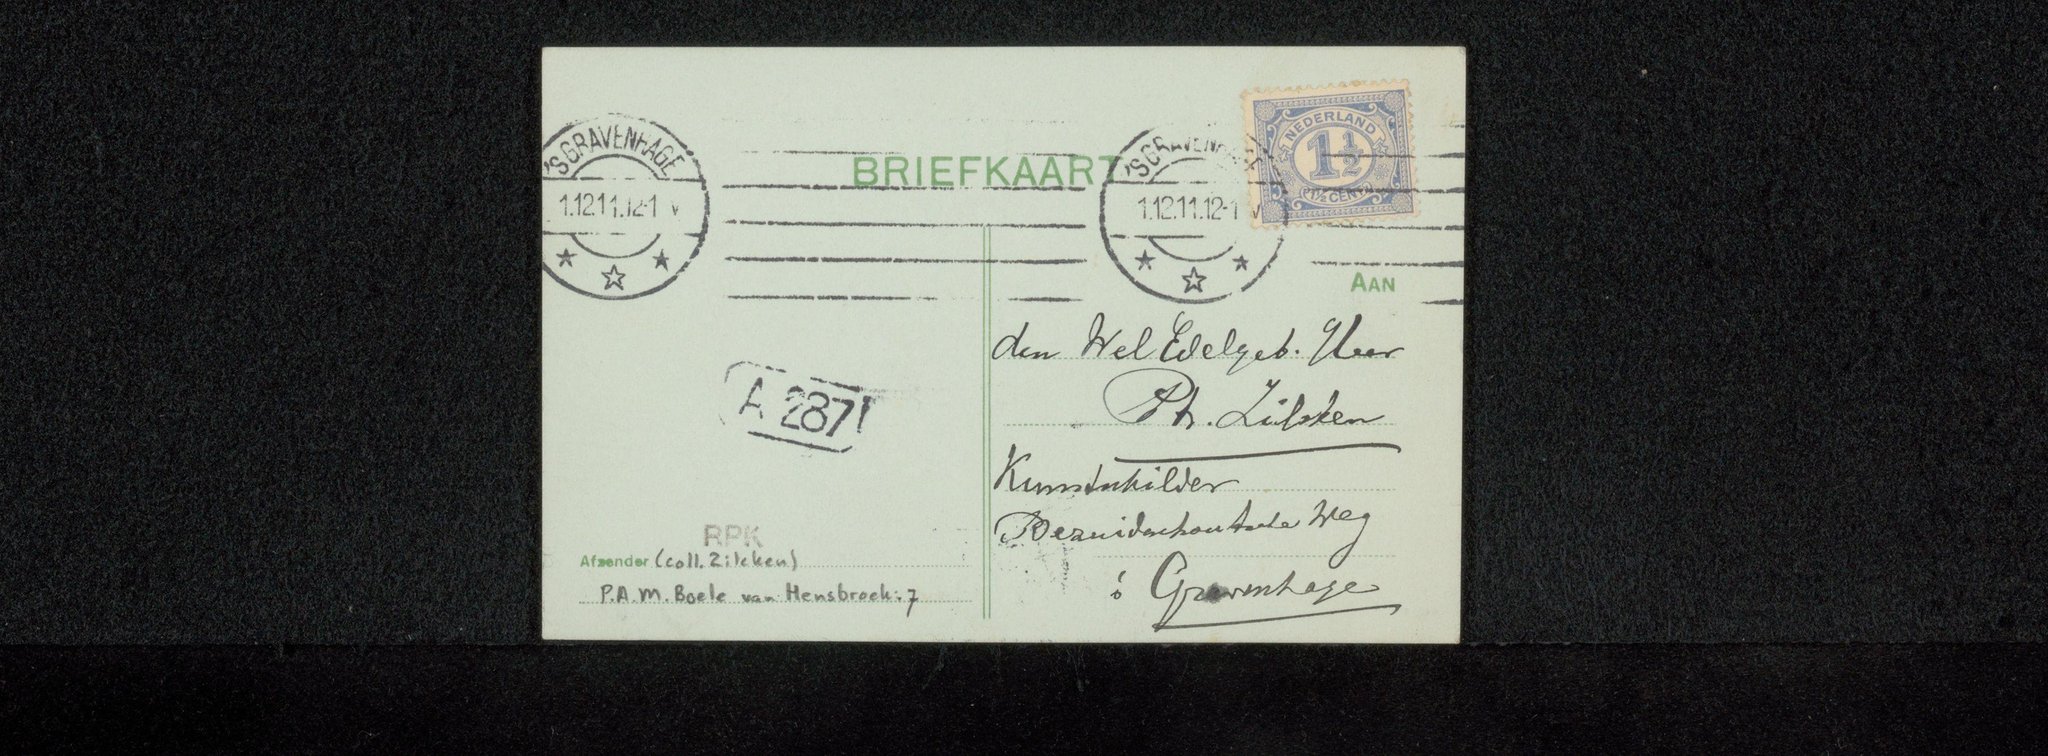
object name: postcard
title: Briefkaart aan Philip Zilcken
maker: pieter andreas martin boele van hensbroek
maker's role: publisher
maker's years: 1853-1912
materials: cardboard, ink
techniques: pen, writing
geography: the hague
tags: print maker, draughtsman, jozef israëls, haarlem, eeltjo aldegondus van beresteijn, coco harms tiepen, philip zilcken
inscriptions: collector's mark: ‘RPK’